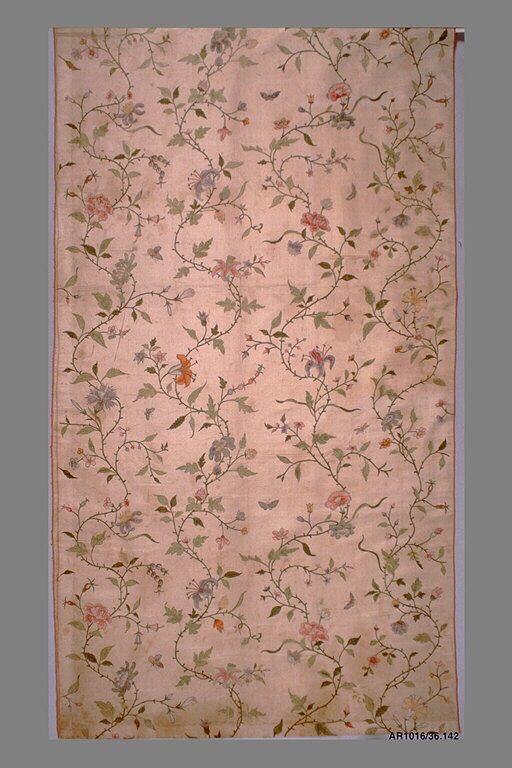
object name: piece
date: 1701-1800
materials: silk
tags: flowers,leaves